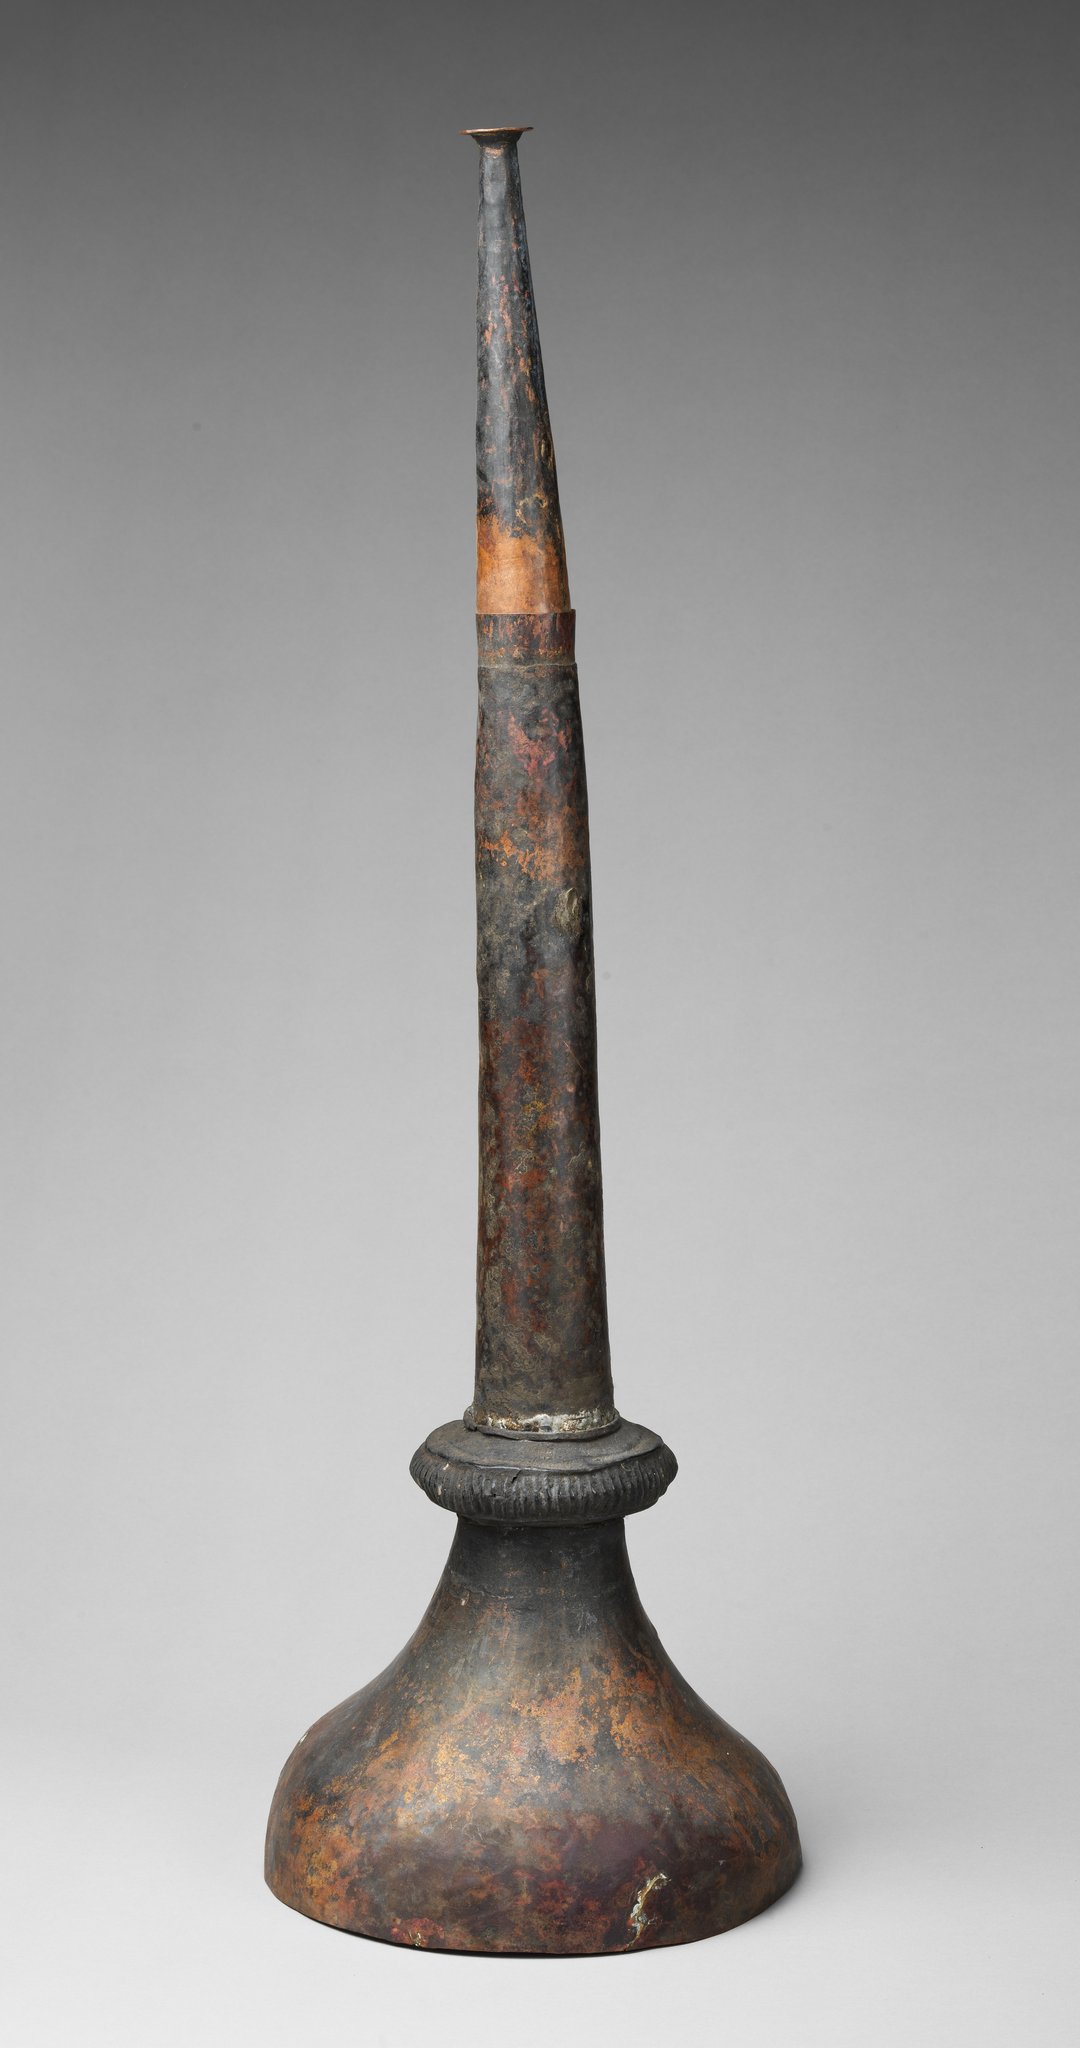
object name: karnāl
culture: nepalese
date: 1801-1900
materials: brass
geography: nepal